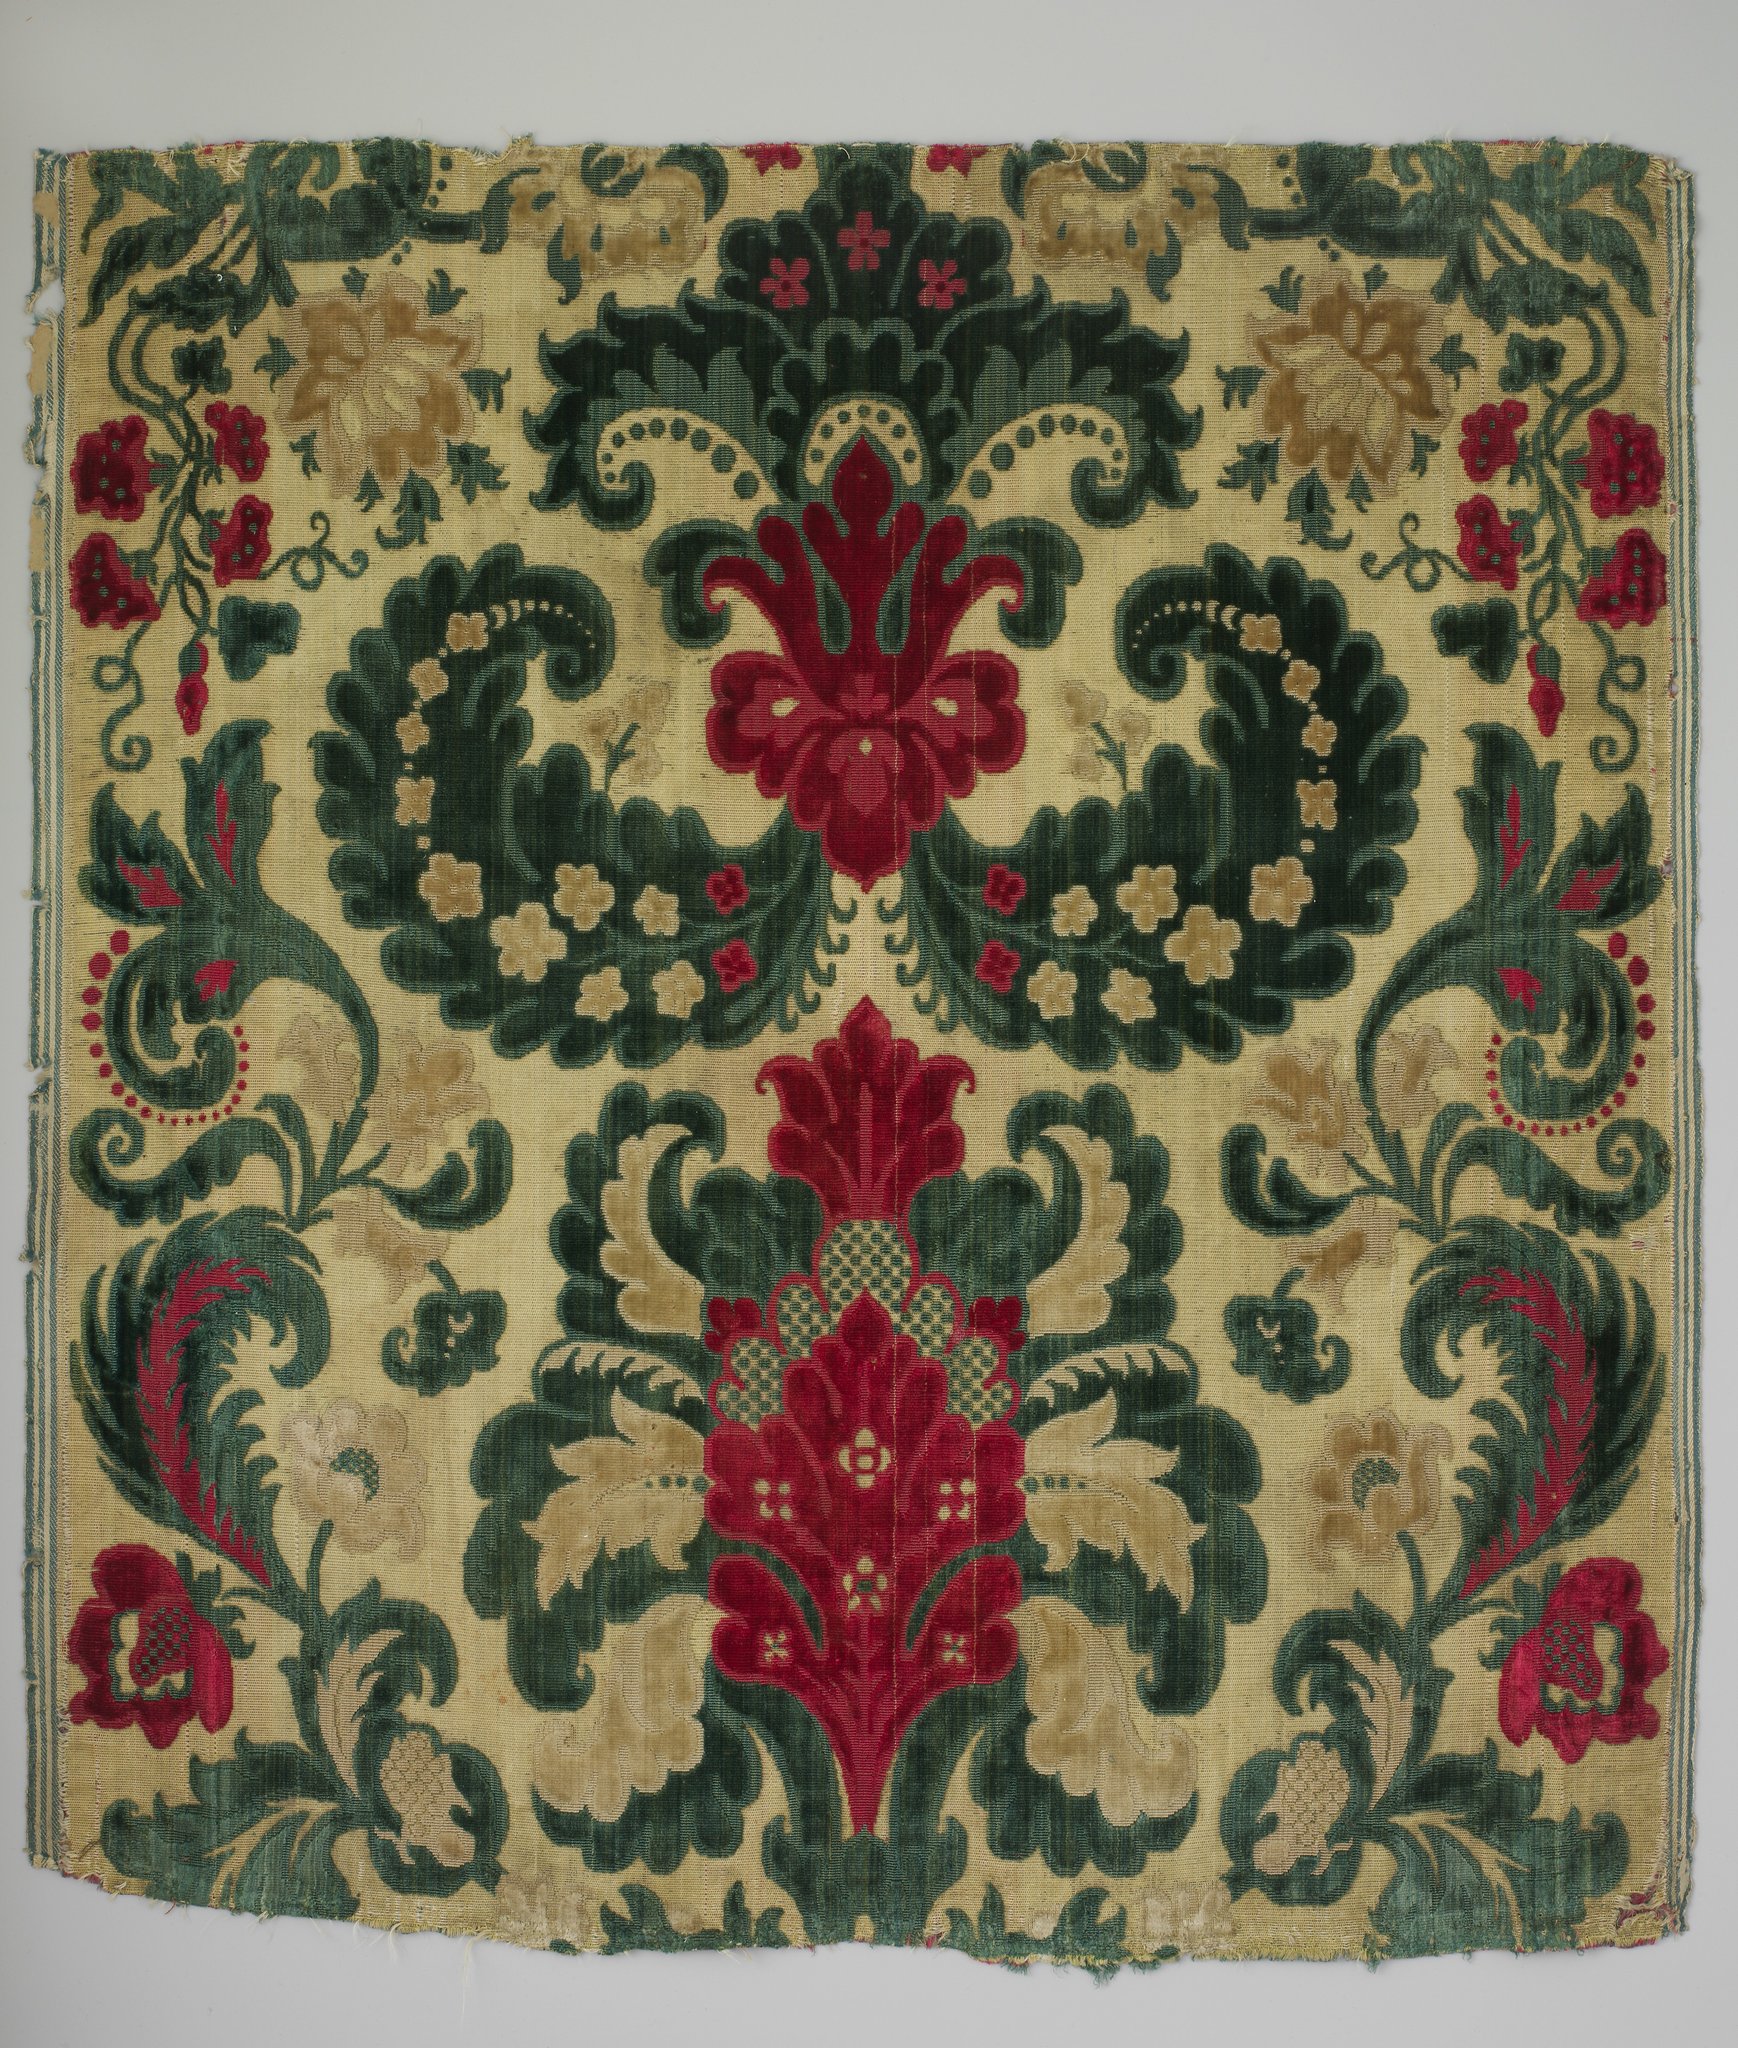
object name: piece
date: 1651-1700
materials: metal thread, silk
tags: flowers,leaves